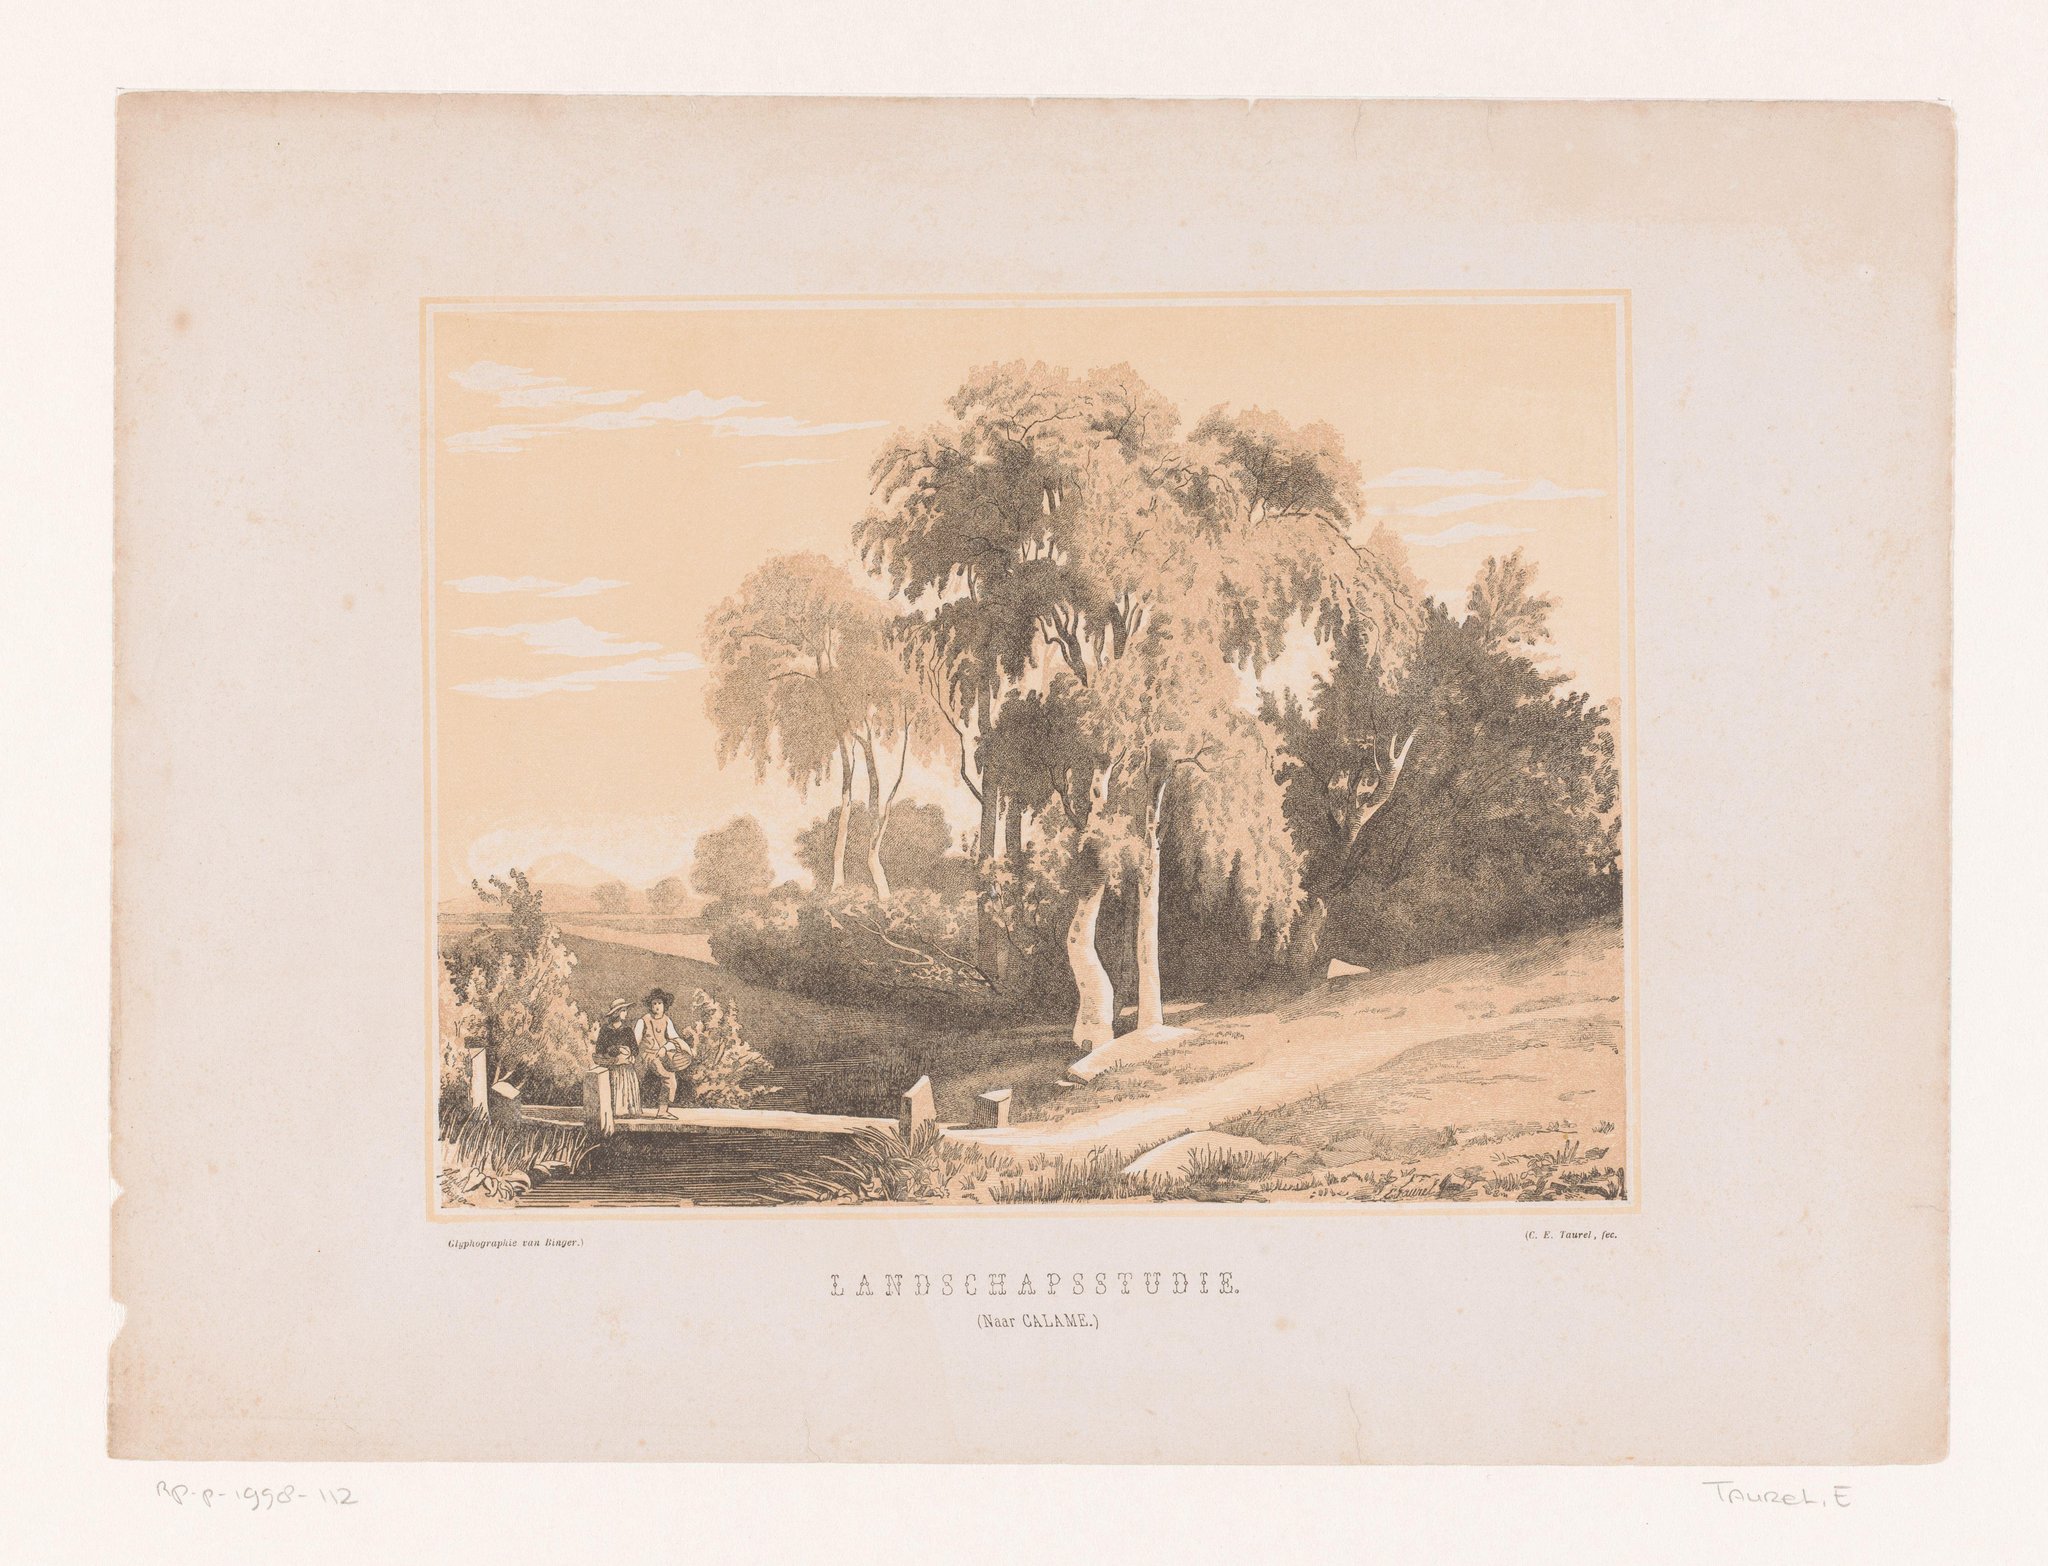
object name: print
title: Landschapsstudie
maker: edouard taurel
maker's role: draughtsman, print maker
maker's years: 1824-1892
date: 1856-1872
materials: paper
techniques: gypsography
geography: amsterdam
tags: landscapes (+ landscape with figures, staffage)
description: Landschapsstudie met een man en een vrouw, lopend over een brug.